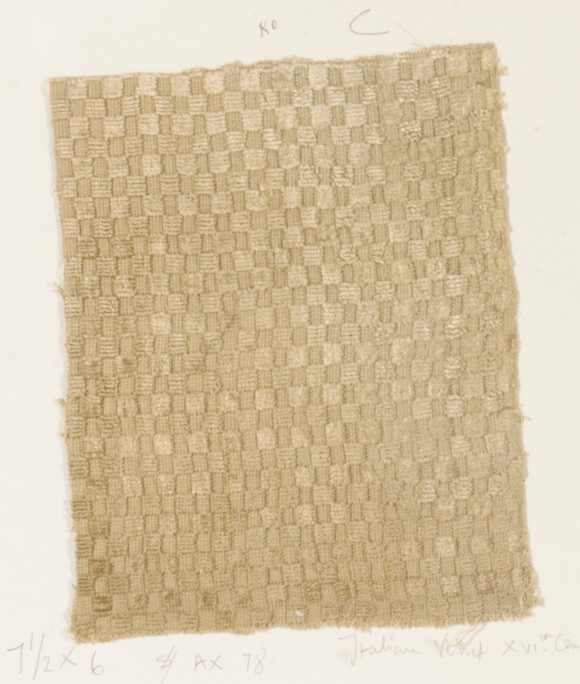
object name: fragment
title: Fragment of velvet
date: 1501-1600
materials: silk